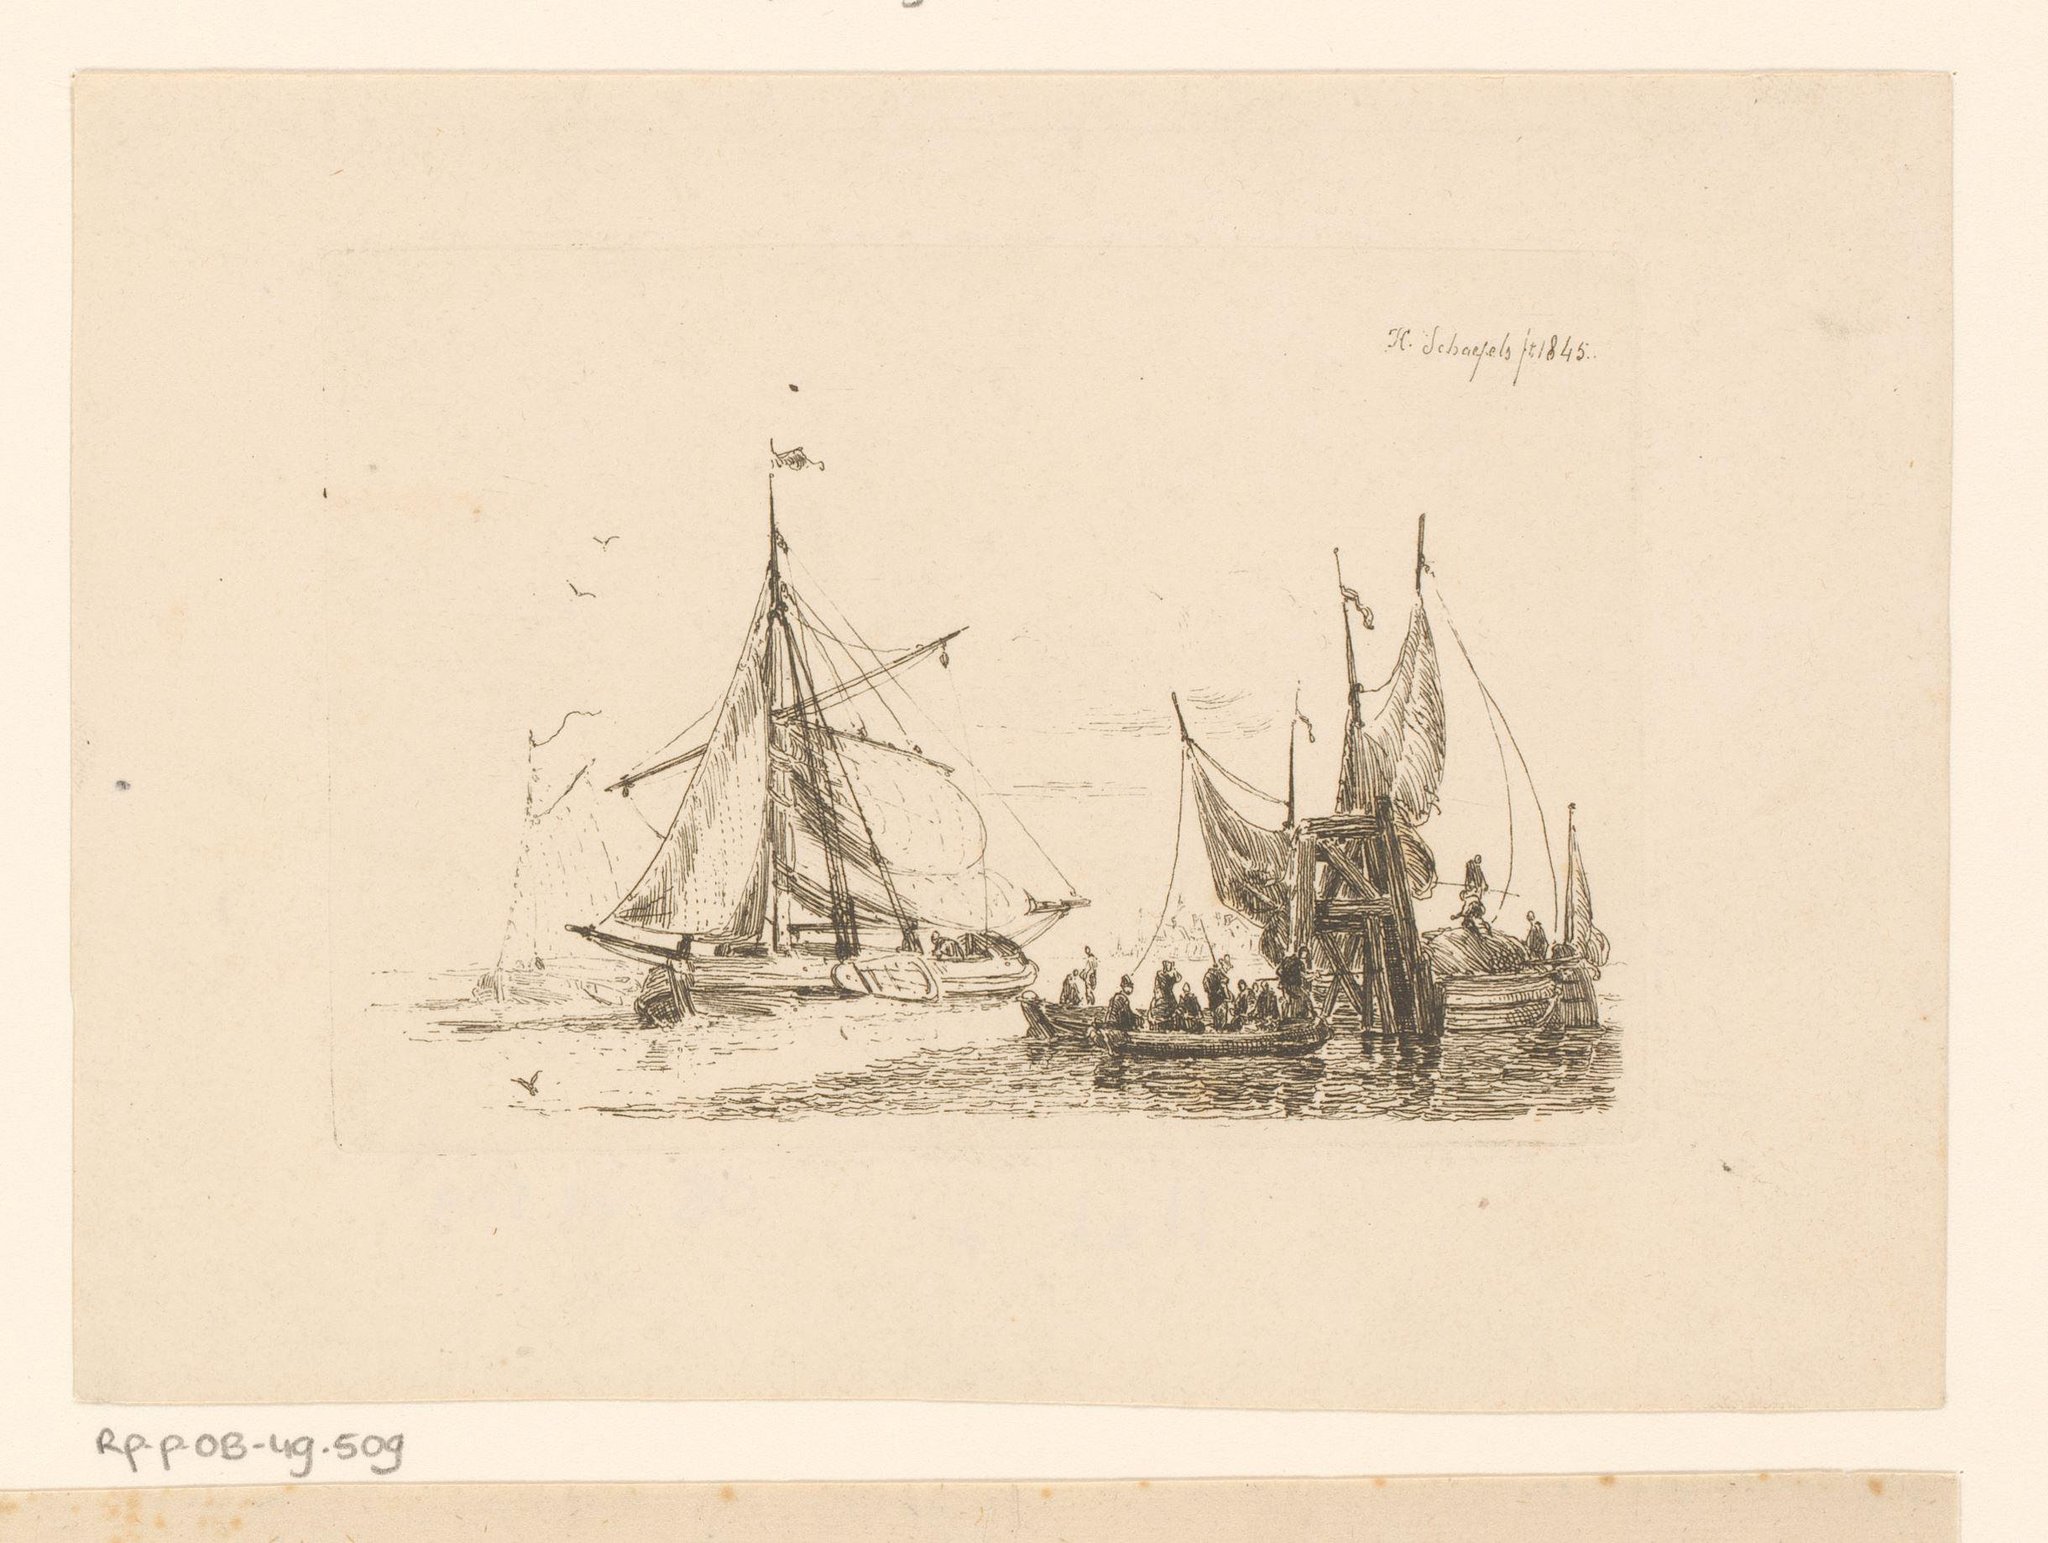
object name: print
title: Boten op het water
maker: henri françois schaefels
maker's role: print maker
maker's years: 1827-1904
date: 1845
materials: paper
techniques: etching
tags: sailing-ship, sailing-boat, landscapes with waters, waterscapes, seascapes (in the temperate zone) (+ landscape with figures, staffage)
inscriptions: collector's mark: Lugt 2228